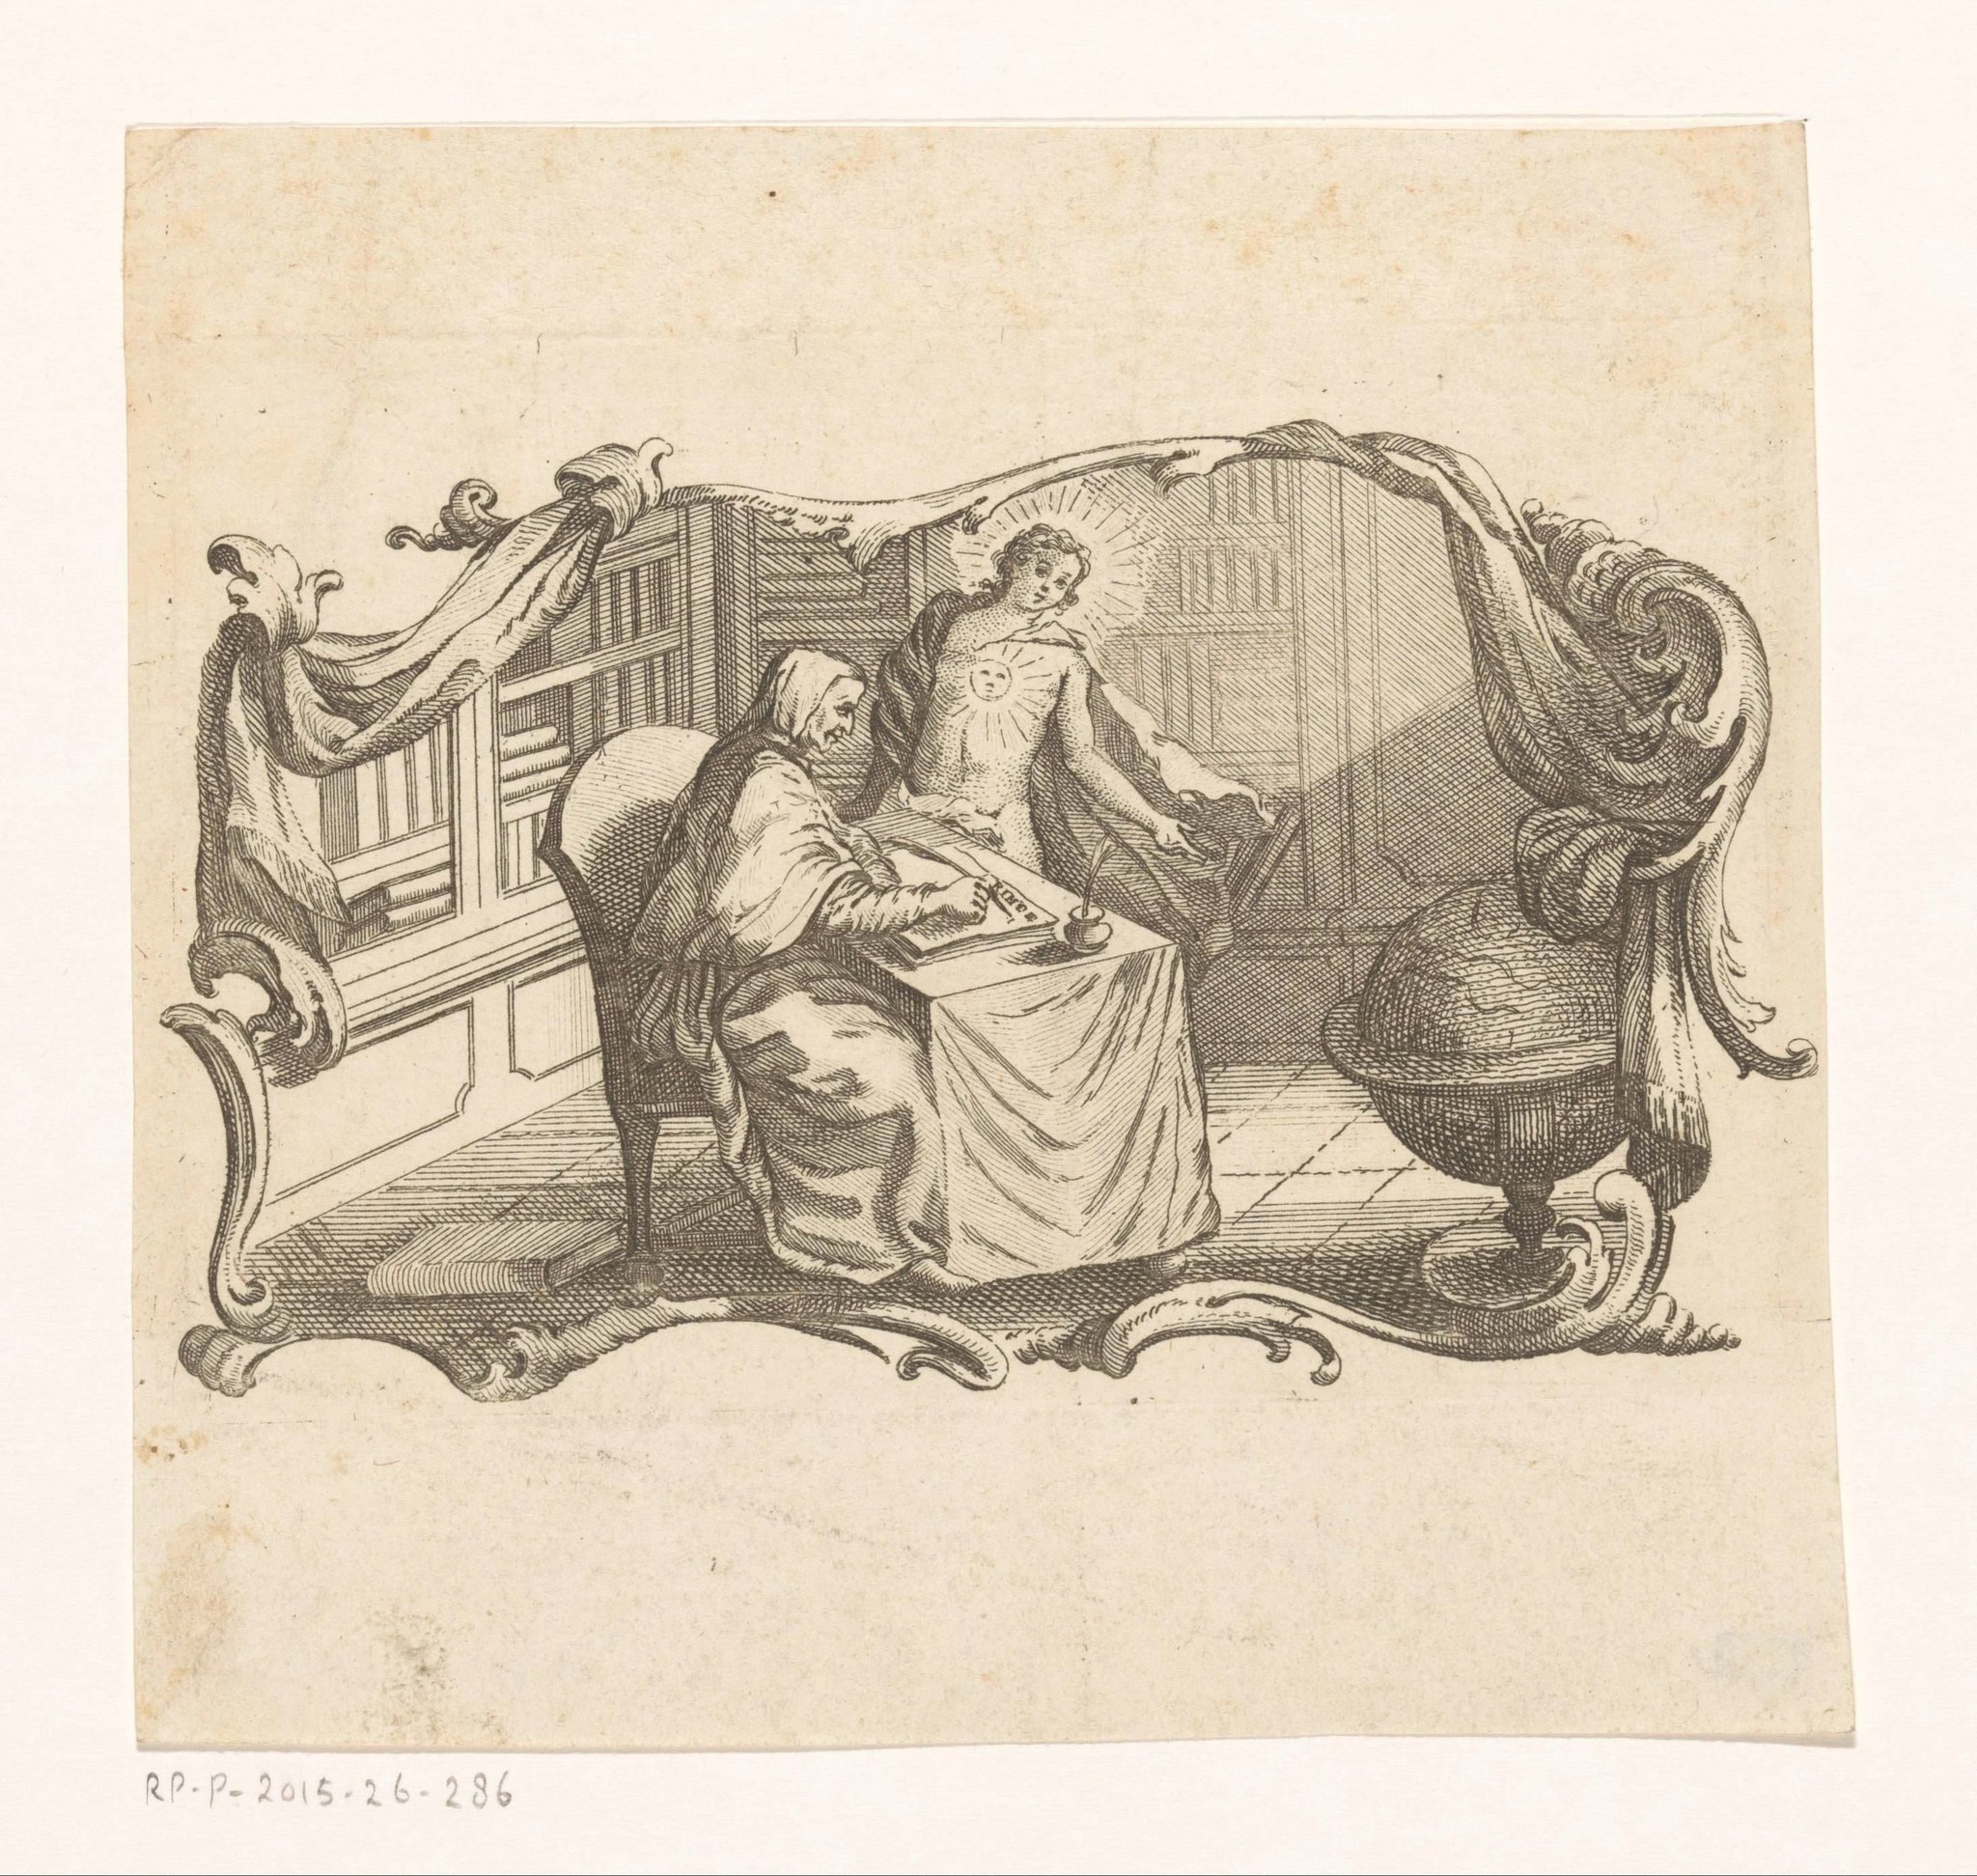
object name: print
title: Schrijver in zijn studeervertrek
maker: Anonymous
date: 1700-1800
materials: paper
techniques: etching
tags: writing-table, writing-desk, bookshelves, acanthus ~ ornament, truth; 'verità' (ripa) (+ abstract concept represented by male figure), study; 'studiolo'; library, globe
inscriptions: collector's mark: Lugt 4779, collector's mark: Lugt 2228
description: Een schrijvende man in een Griekse toga achter een tafel in een studeervertrek. Naast zijn tafel staat de personificatie van de waarheid. Tegen de wanden staan boekenkasten, op de grond een globe. In omlijsting met acanthus motieven.